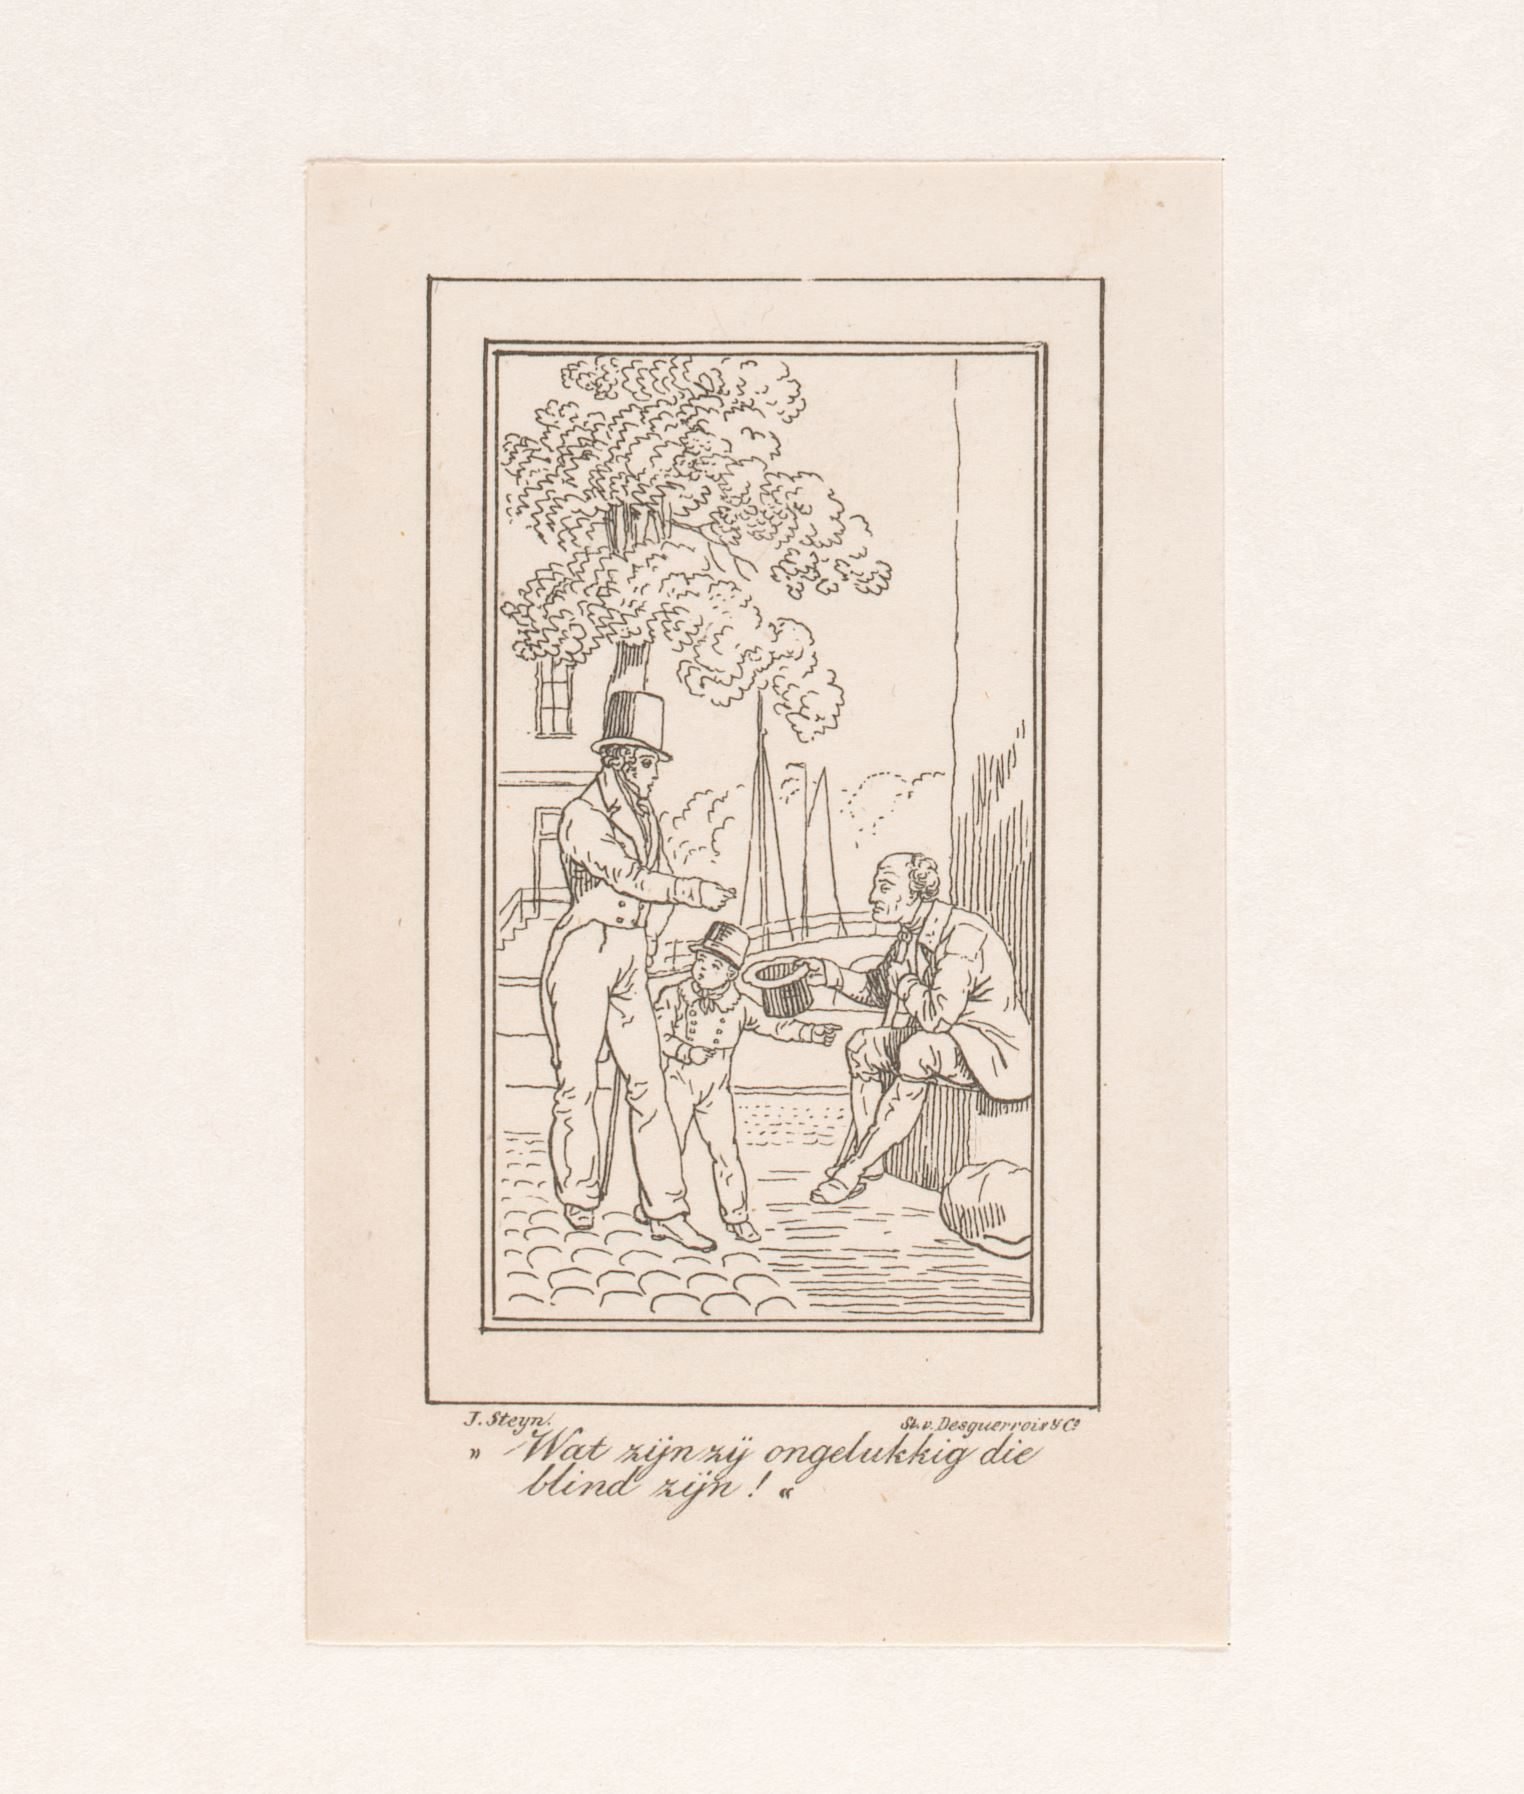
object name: book illustration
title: Wat zijn zij ongelukkig die blind zijn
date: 1836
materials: paper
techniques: lithograph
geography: amsterdam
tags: blind, blindness, contrast between rich and poor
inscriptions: collector's mark: Lugt 2228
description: Prent uit: S.n. De vriend der jeugd, een geschenk voor betoonde vlijt. Amsterdam: Koster, Cornelis Johannes, 1836.